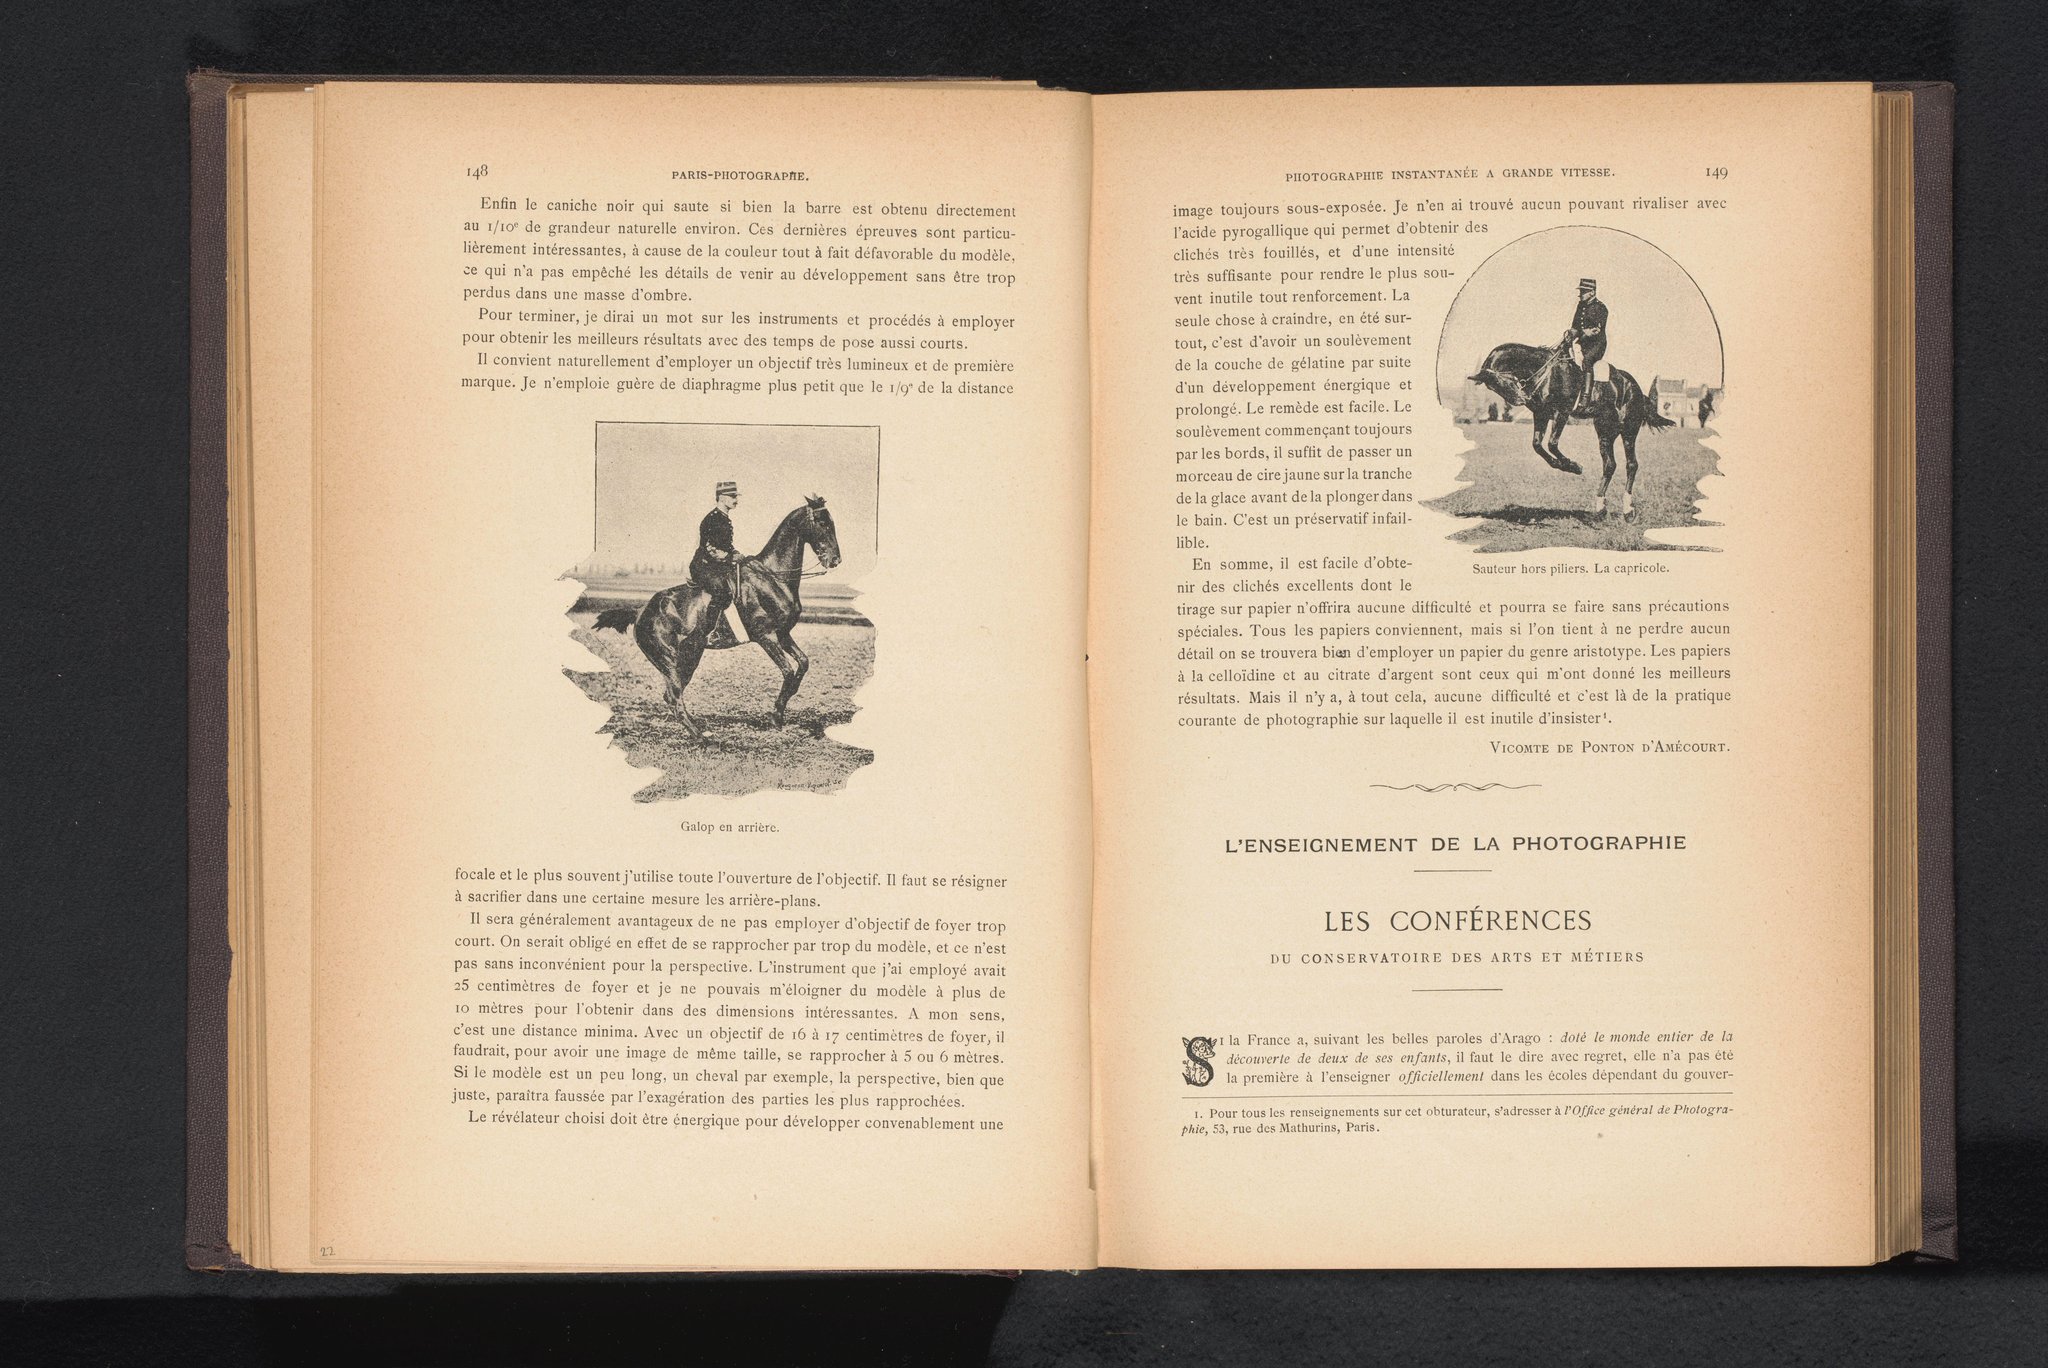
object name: photomechanical print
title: Sauteur hors piliers. La capricole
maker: Anonymous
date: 1883-1893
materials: paper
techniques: autotype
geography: france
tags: riding a horse, ass, or mule; rider, horseman, jumping (horse in motion), horse